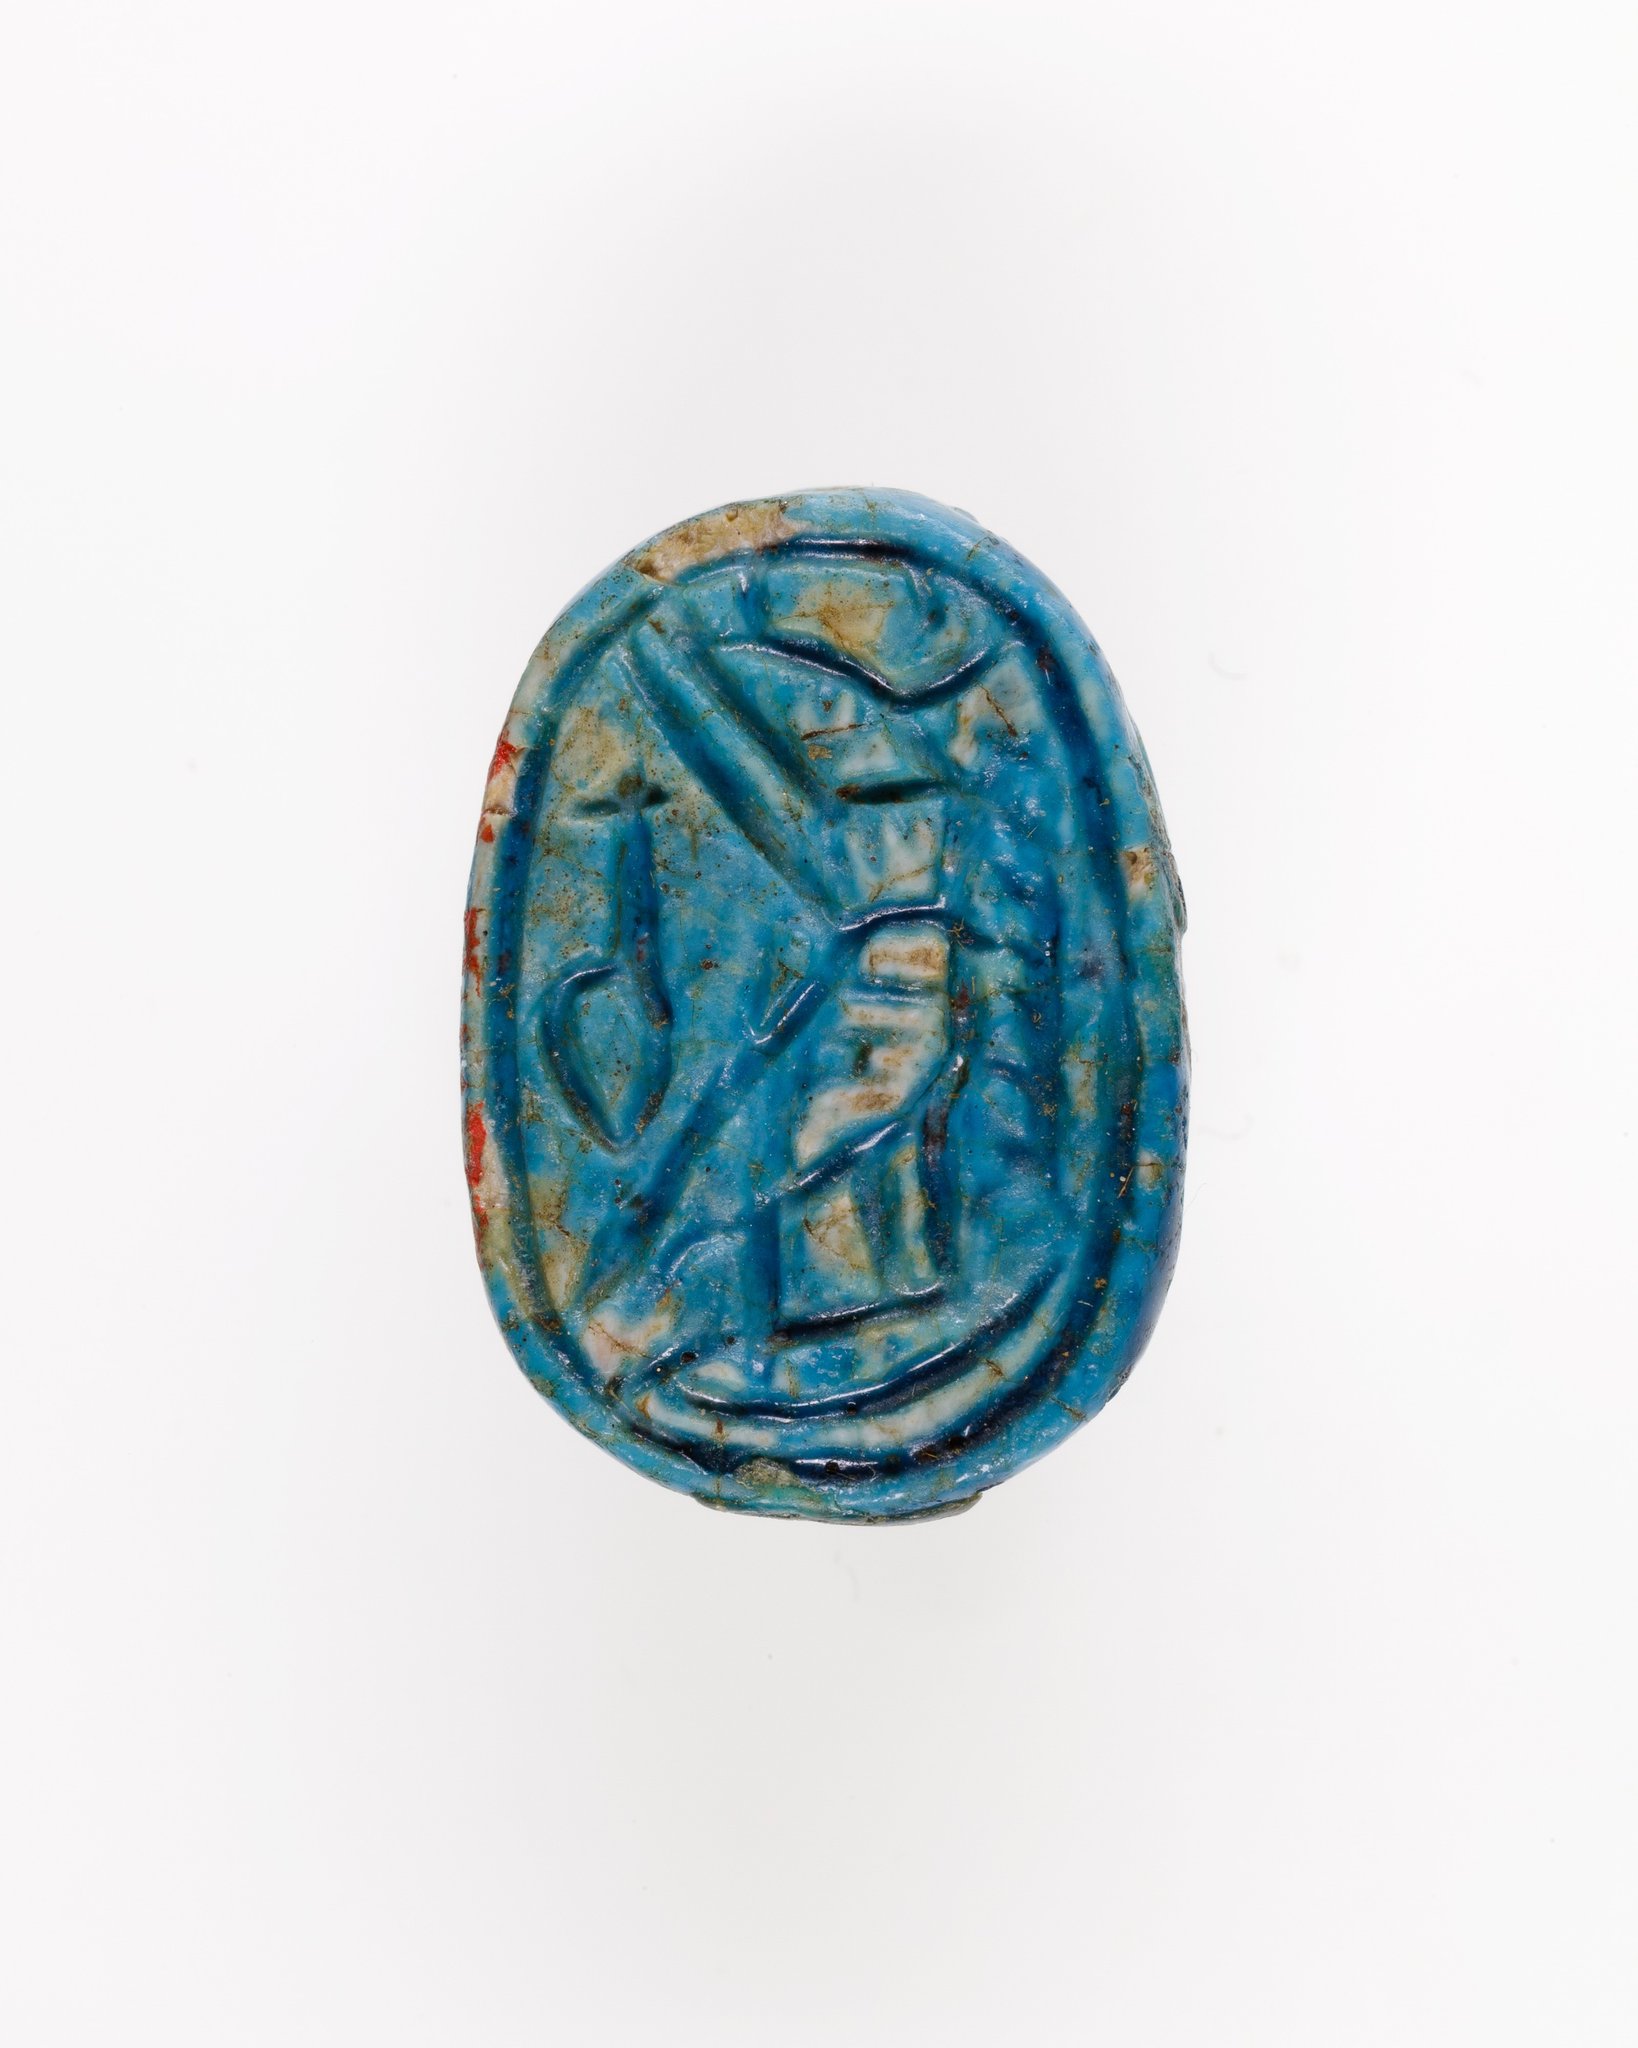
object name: scarab, falcon wearing double crown, nefer, branch, nb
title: Scarab with the Representation of a Falcon and Hieroglyphs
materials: stone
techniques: glazing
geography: egypt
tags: scarabs